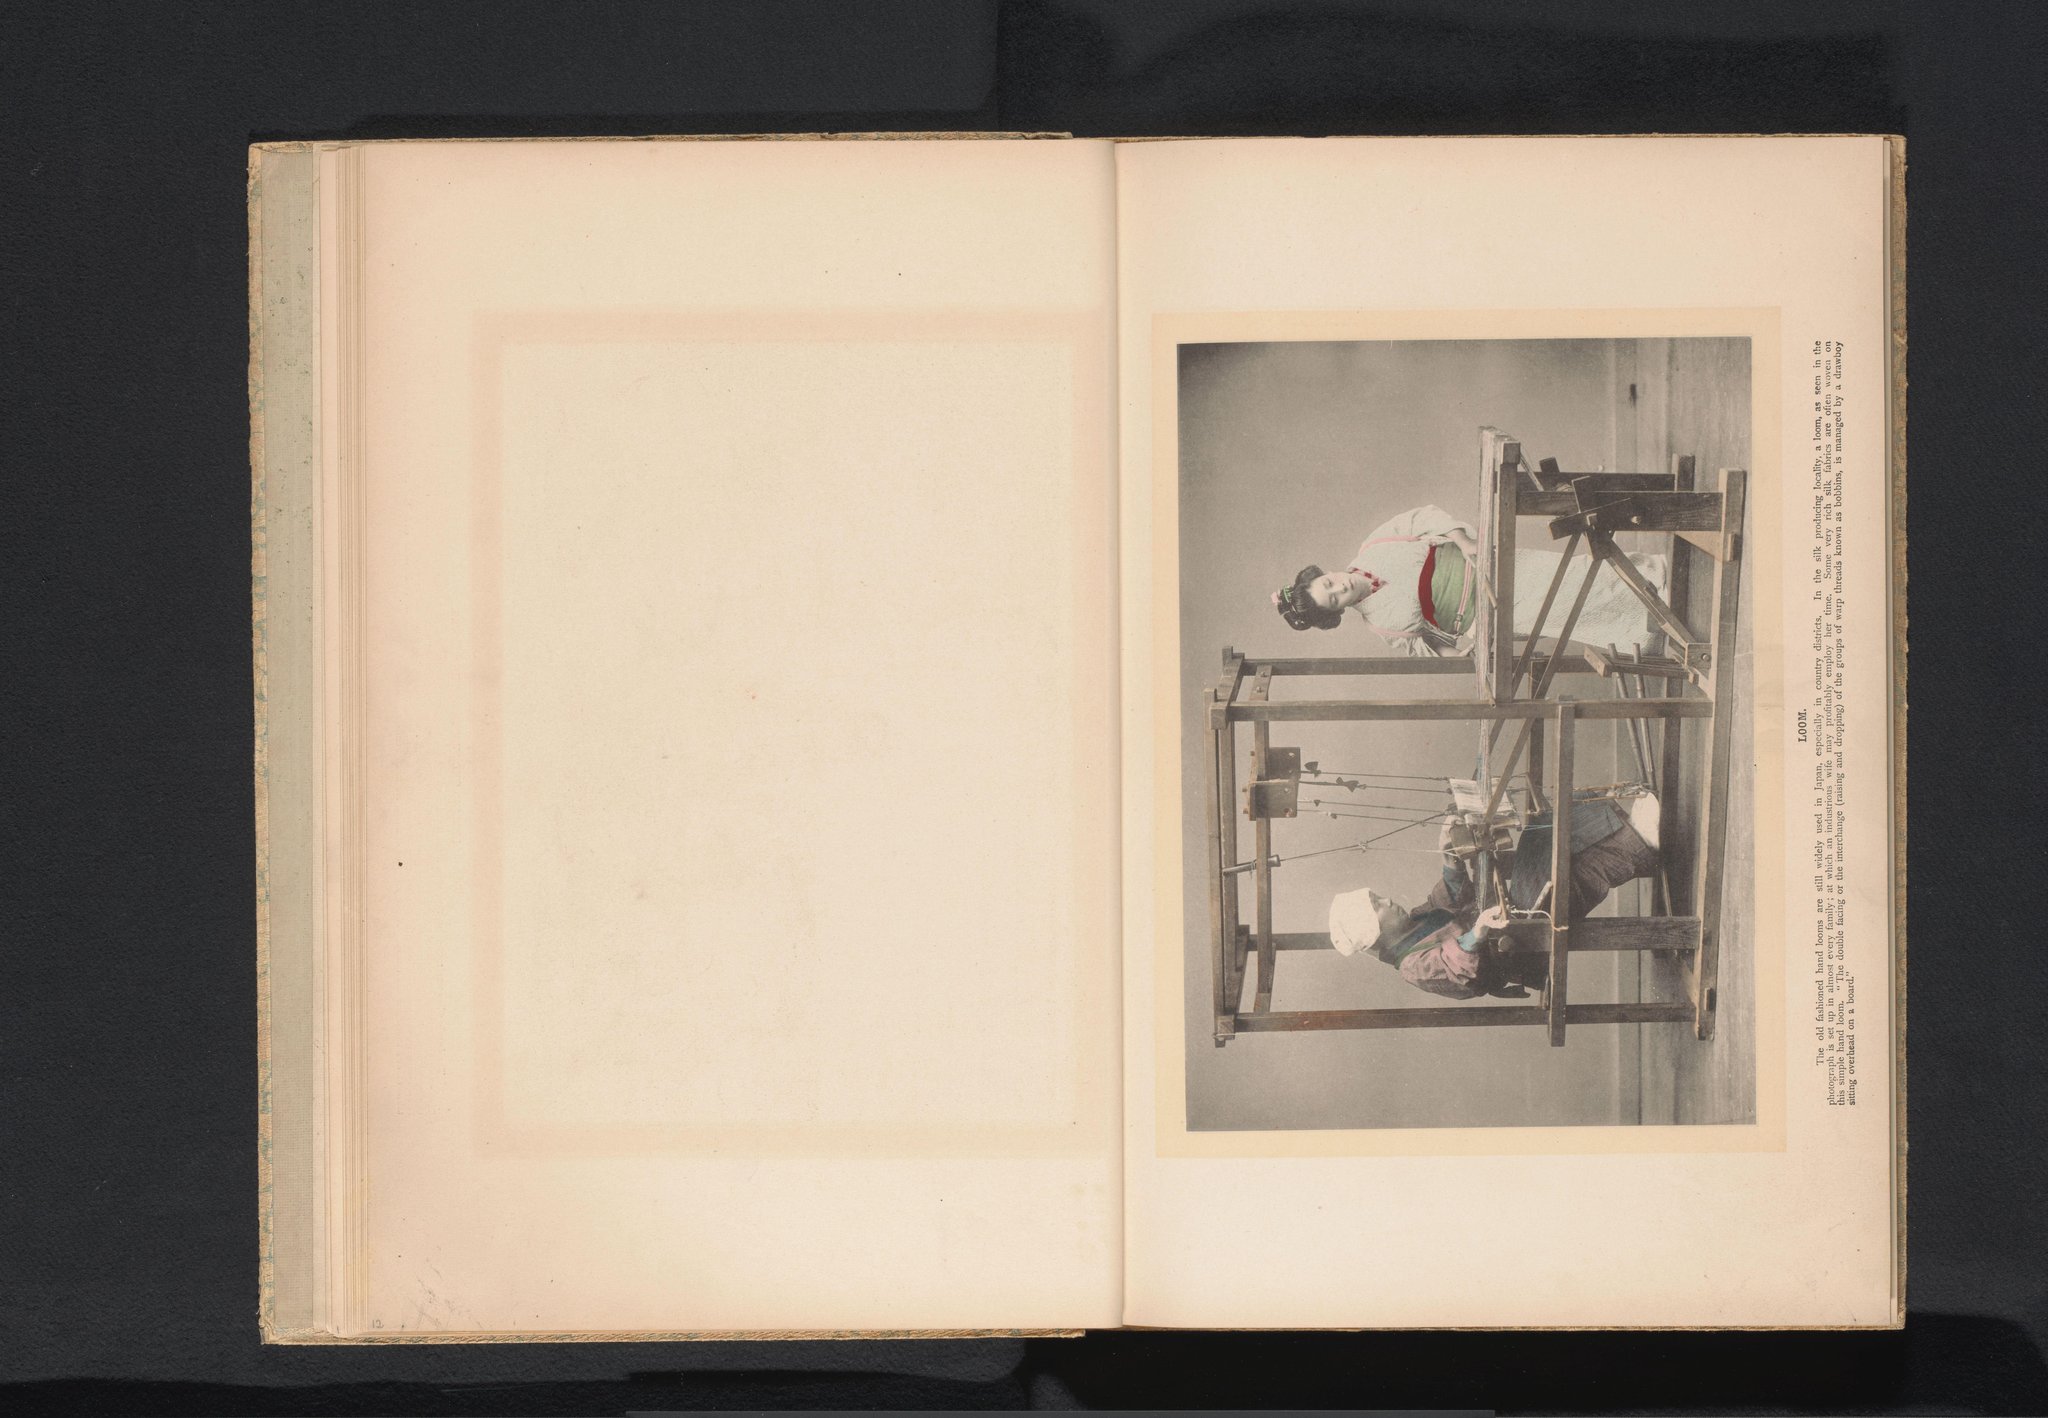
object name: page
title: Twee vrouwen werken met een weefgetouw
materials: paper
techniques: photograph, lithograph, hand coloring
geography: japan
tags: weaving-loom (+ women (labourers)), japan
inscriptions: inscription: ‘The old (...) a board.’